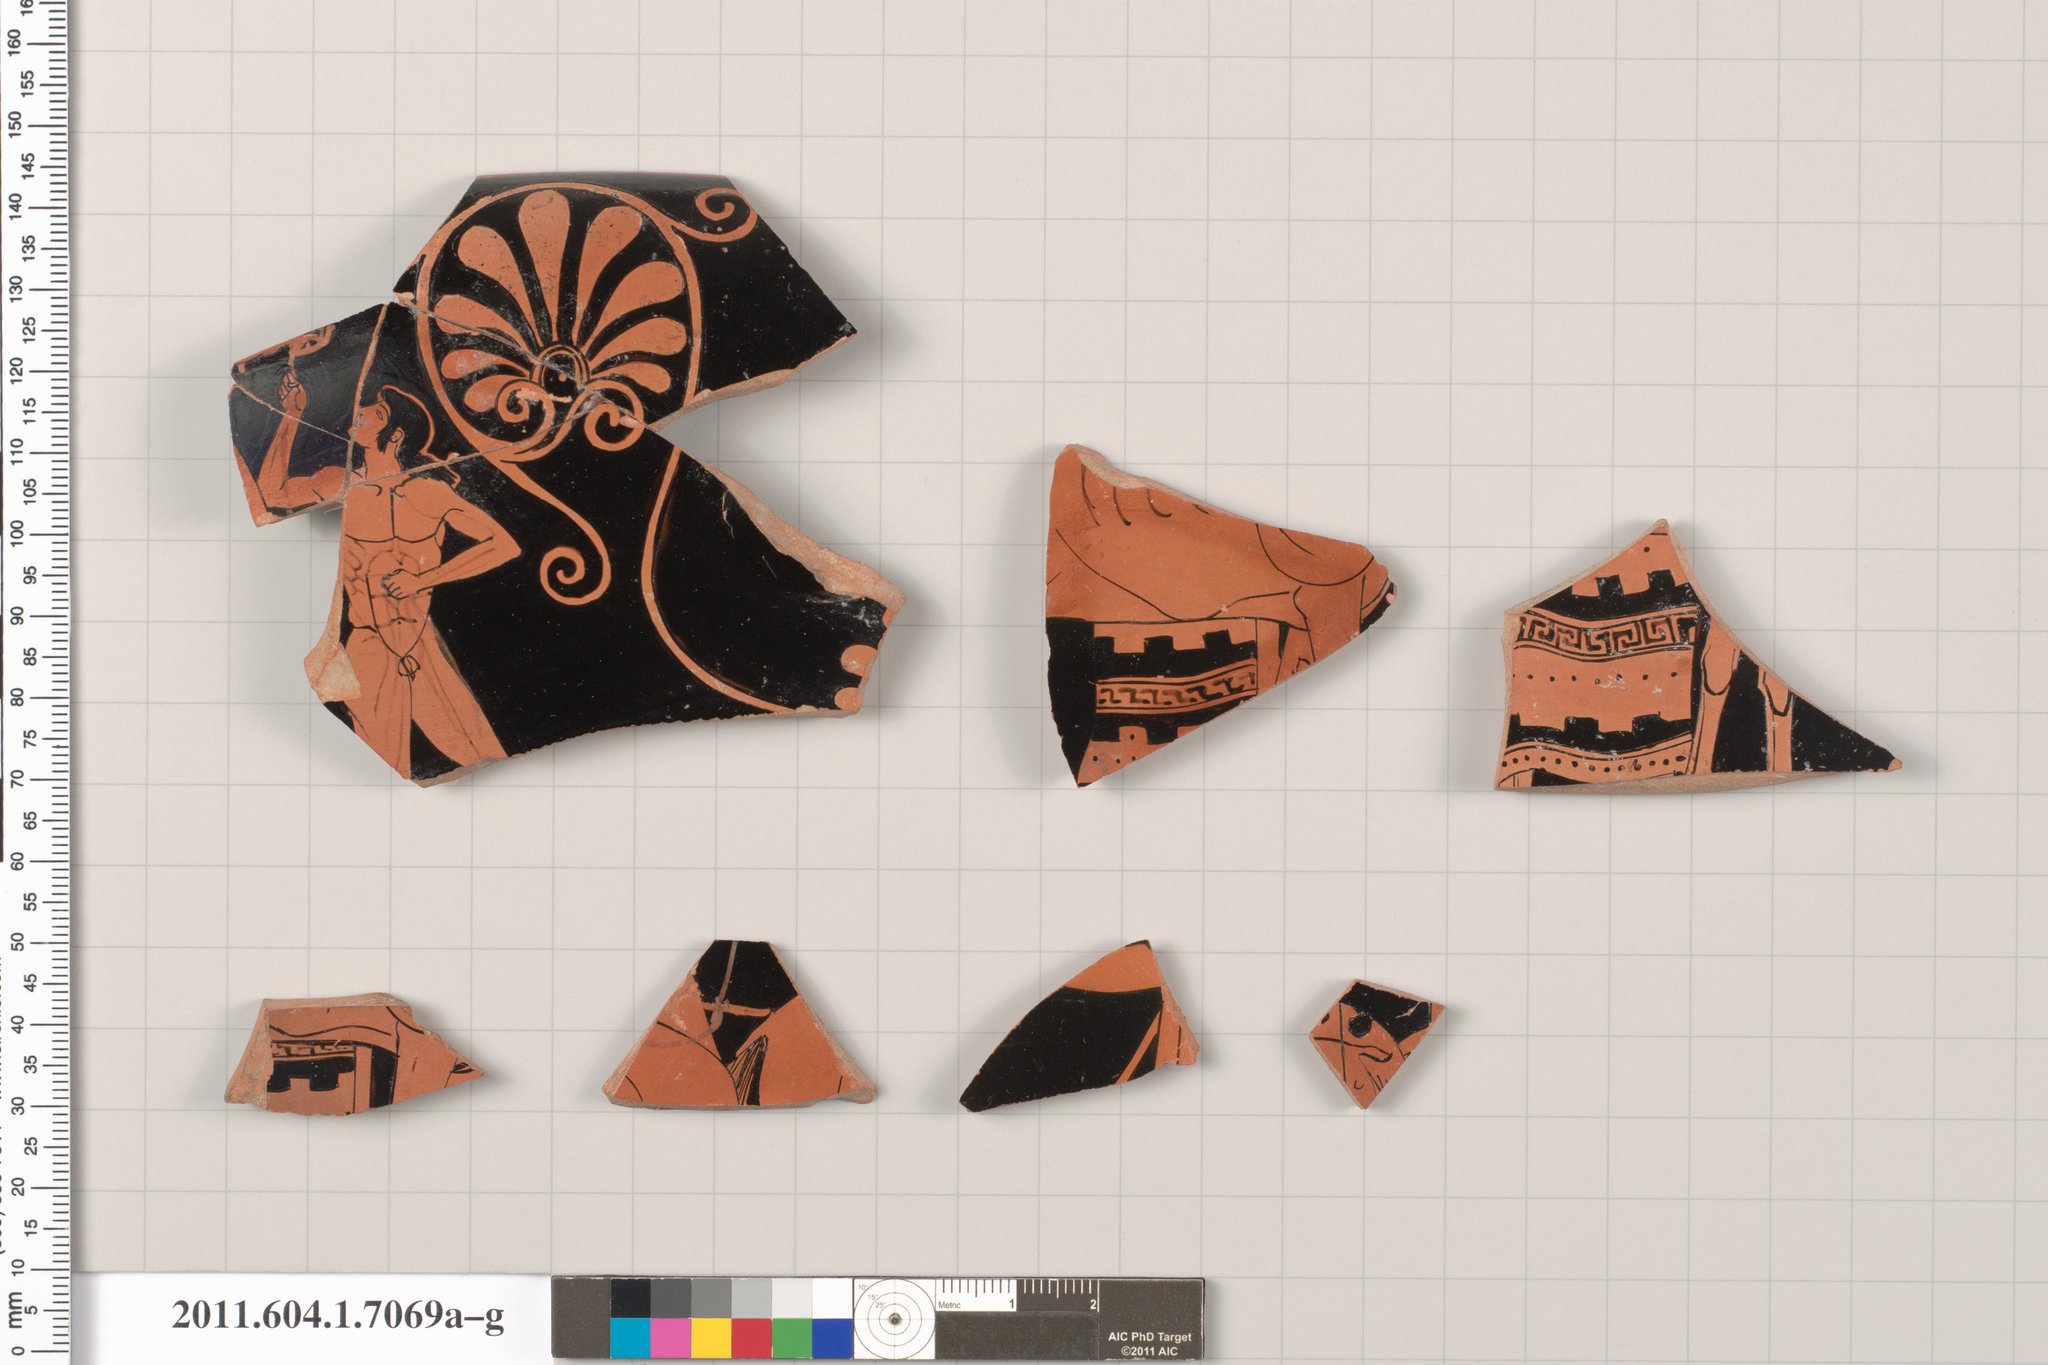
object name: kylix fragment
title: Terracotta fragments of a kylix (drinking cup)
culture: greek, attic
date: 500-480 BCE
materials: terracotta